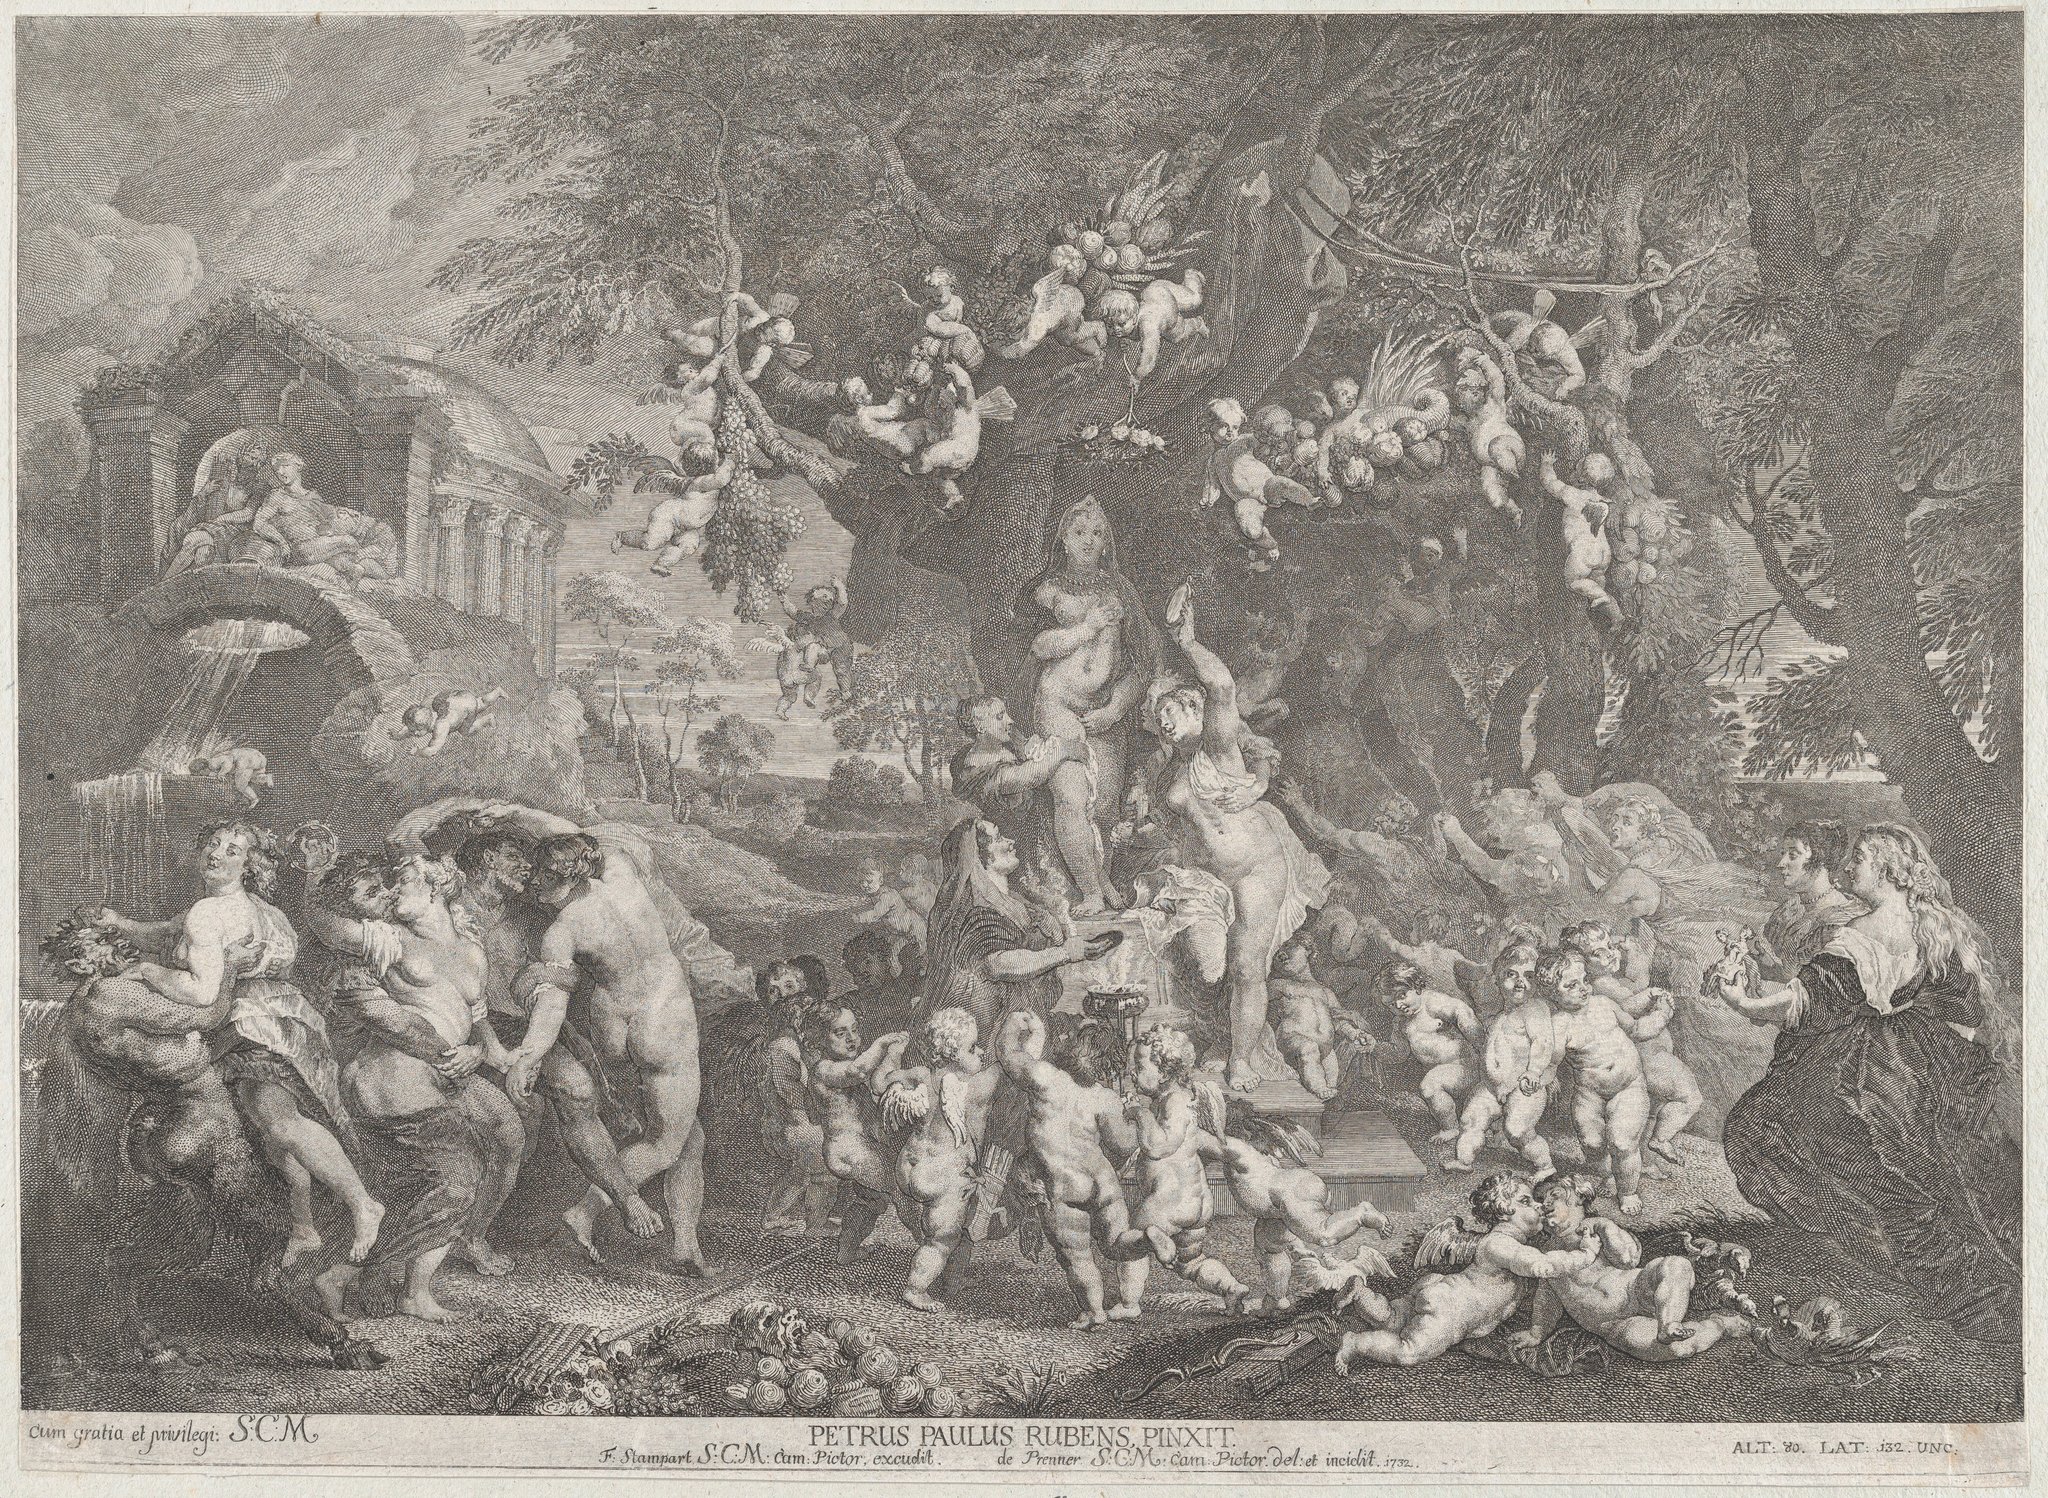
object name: print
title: The Feast of Venus, with groups of satyrs, nymphs, and putti dancing around a statue of Venus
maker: anton joseph von prenner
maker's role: artist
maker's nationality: austrian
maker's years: 1683-1761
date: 1732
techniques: etching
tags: nymphs,putti,venus,satyrs